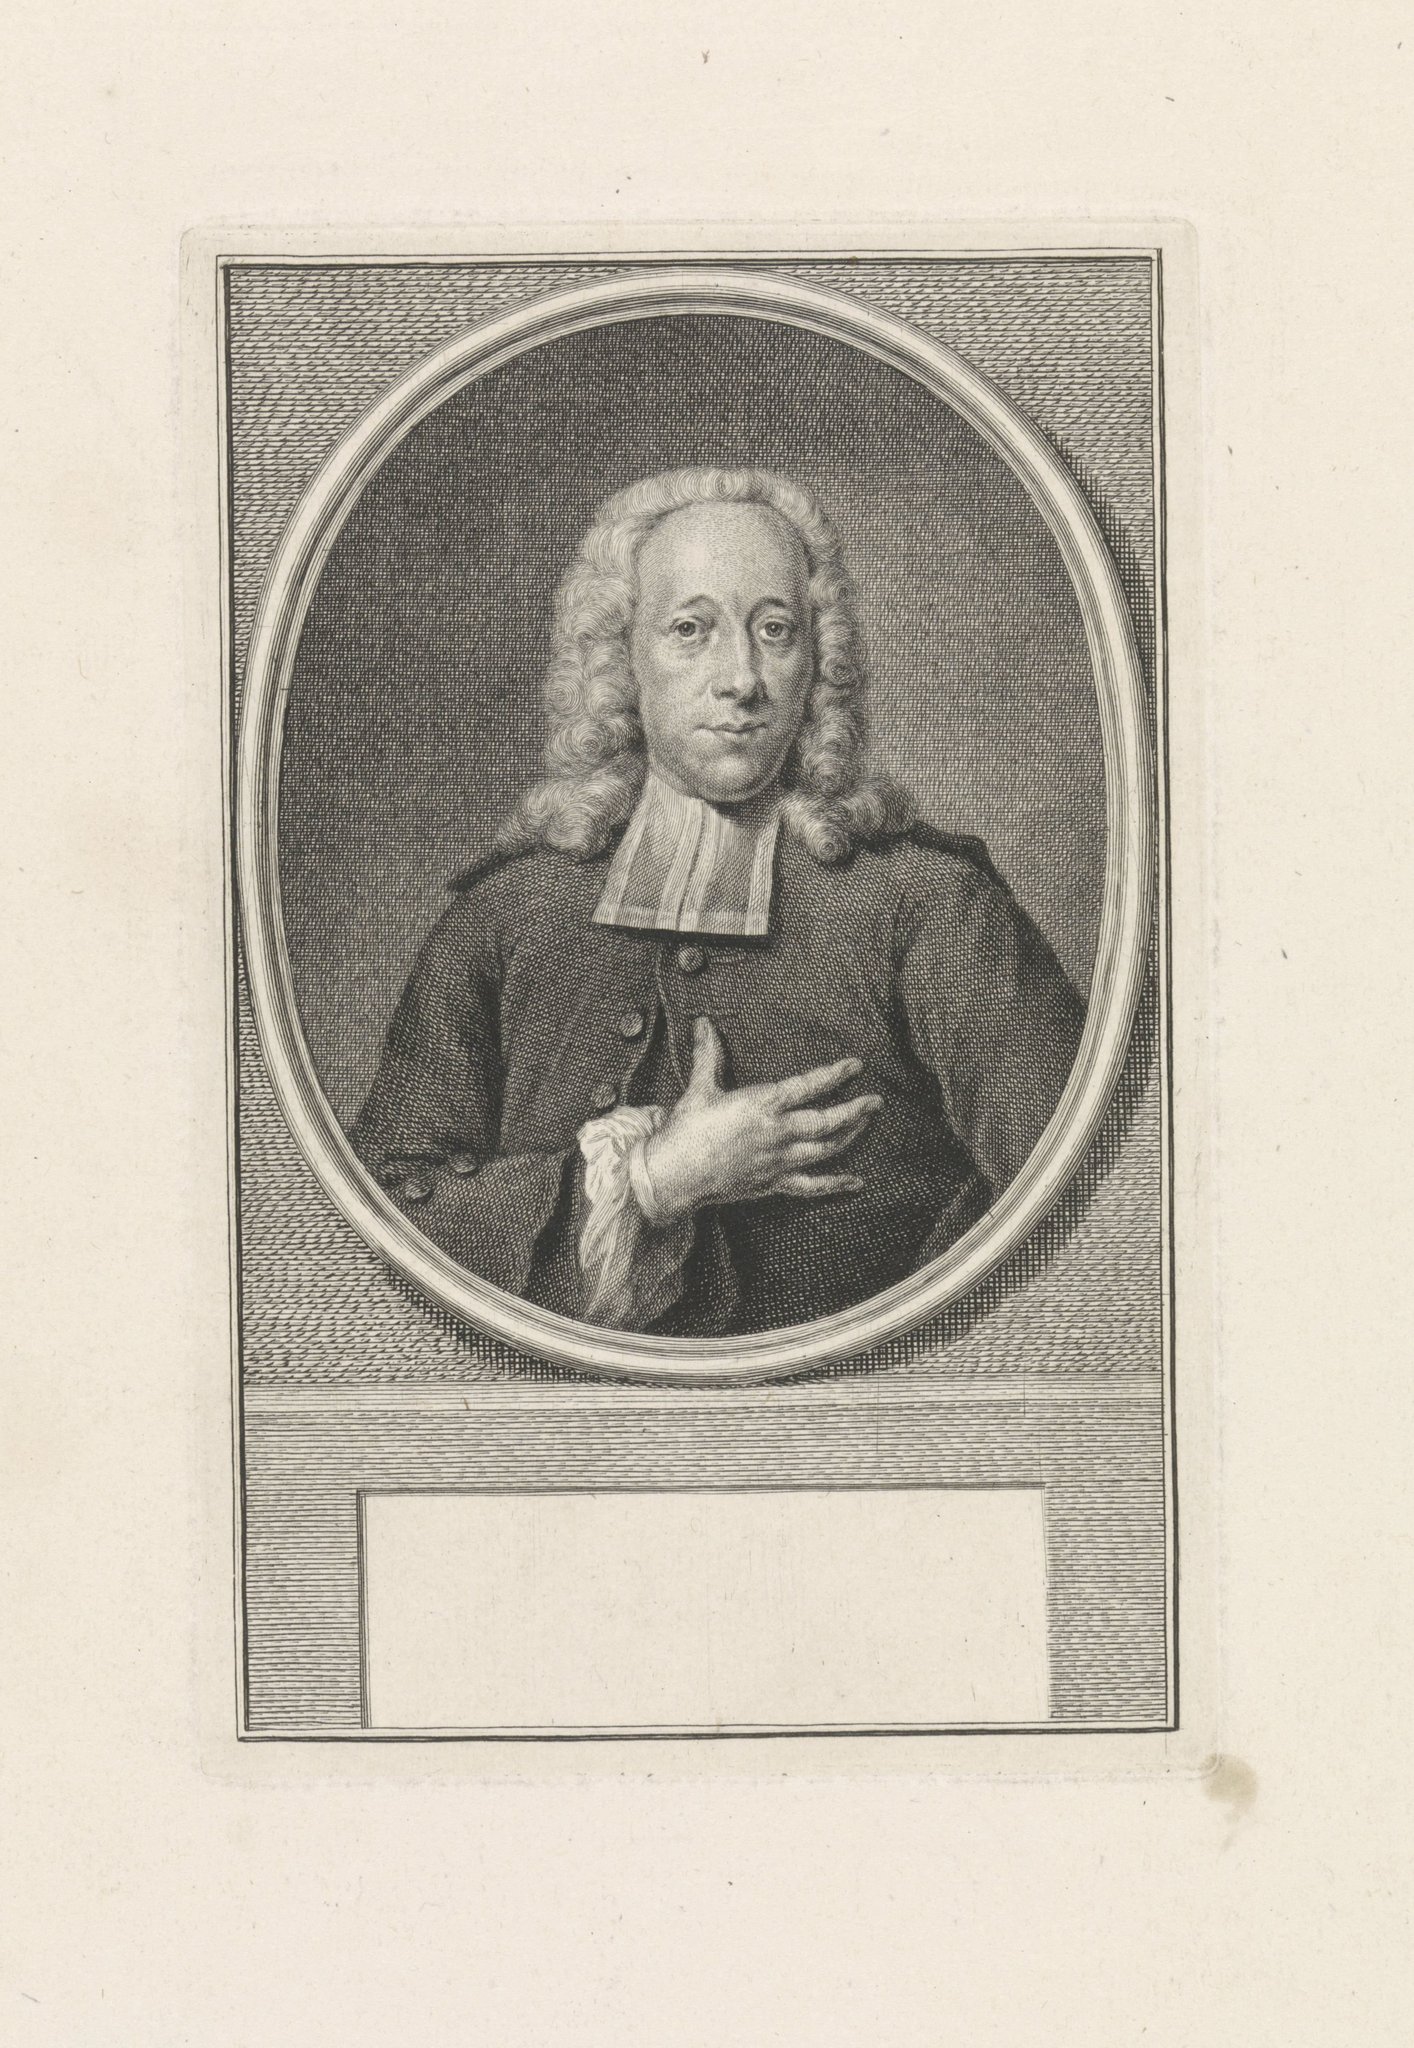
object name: print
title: Portret van Johan Temmink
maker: jacob houbraken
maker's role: draughtsman, print maker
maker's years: 1698-1780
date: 1766-1768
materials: paper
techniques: engraving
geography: amsterdam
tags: vlaardingen, predikant, johan temmink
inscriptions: collector's mark: Lugt 2228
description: Portret ten halven lijve van Johan Temmink in een ovaal medaillon. Het portret rust op een richel waarop zijn naam en gegevens in acht regels in het Nederlands.